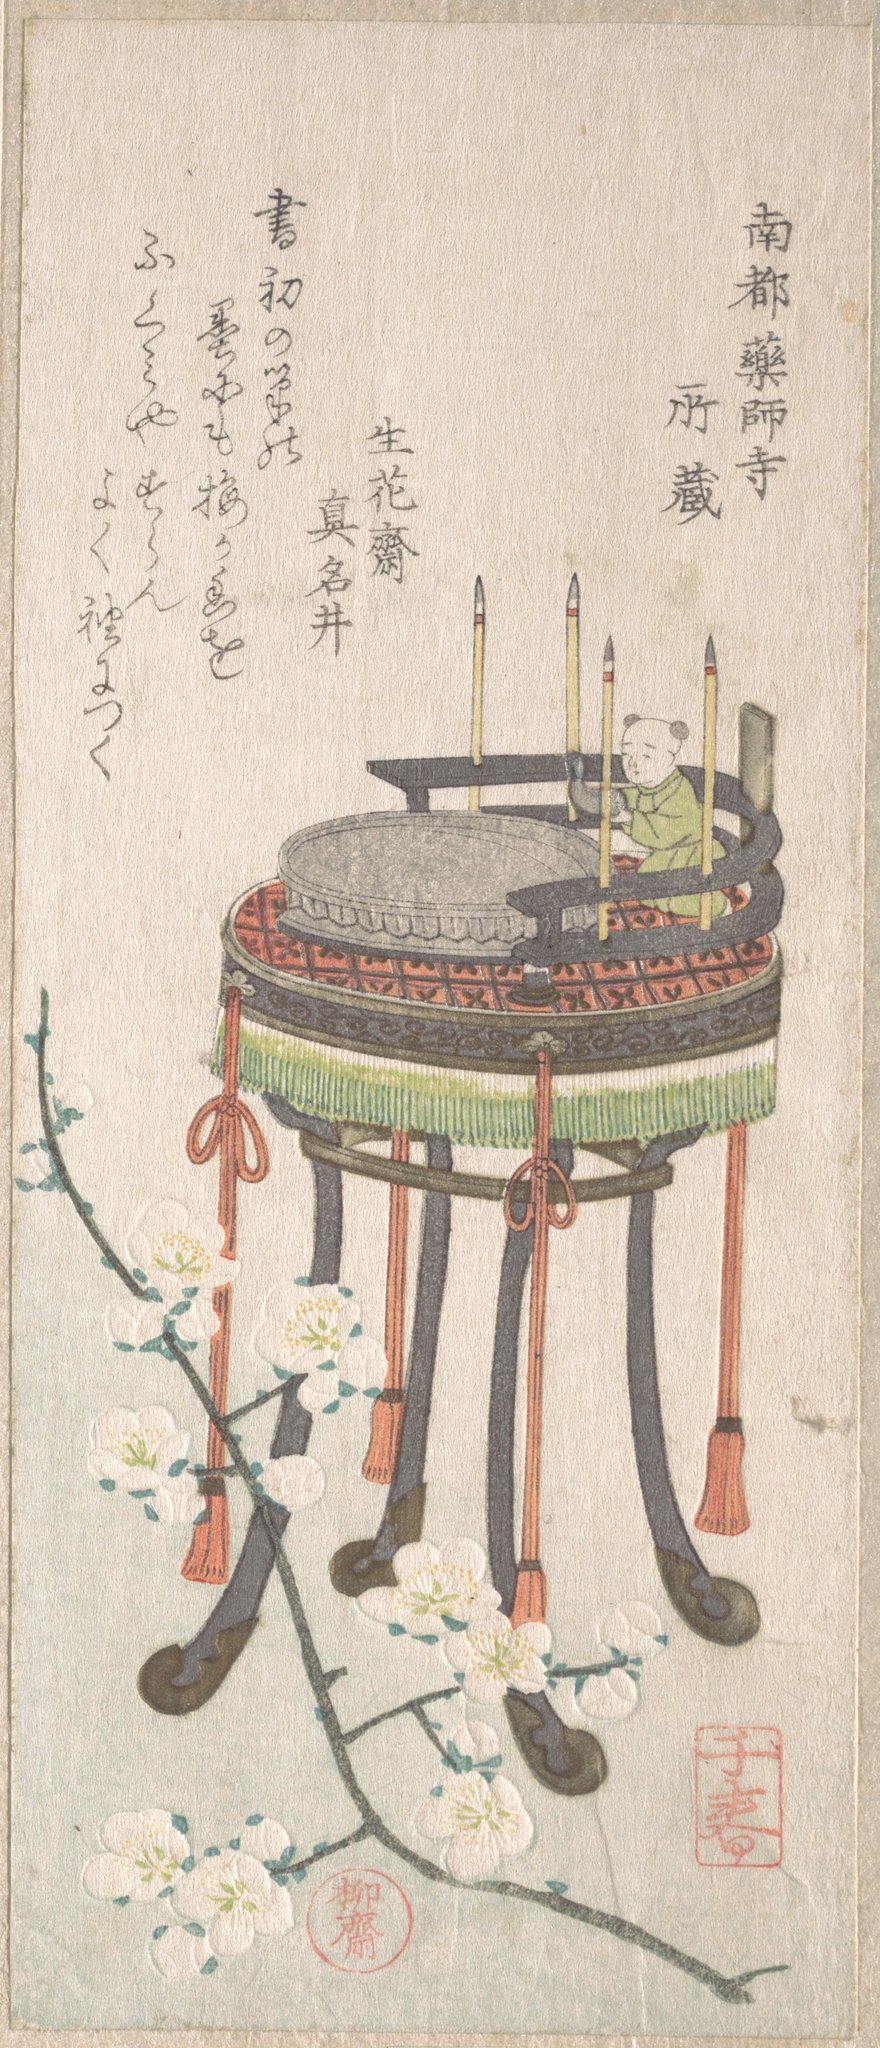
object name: woodblock print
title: Plum Branch with Flowers and a Stand with a Writing Set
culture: japanese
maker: takashima chiharu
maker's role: artist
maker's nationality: japanese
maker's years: 1777-1859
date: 1801-1900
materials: ink, paper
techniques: surimono, woodblock print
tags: flowers,writing implements,brushes